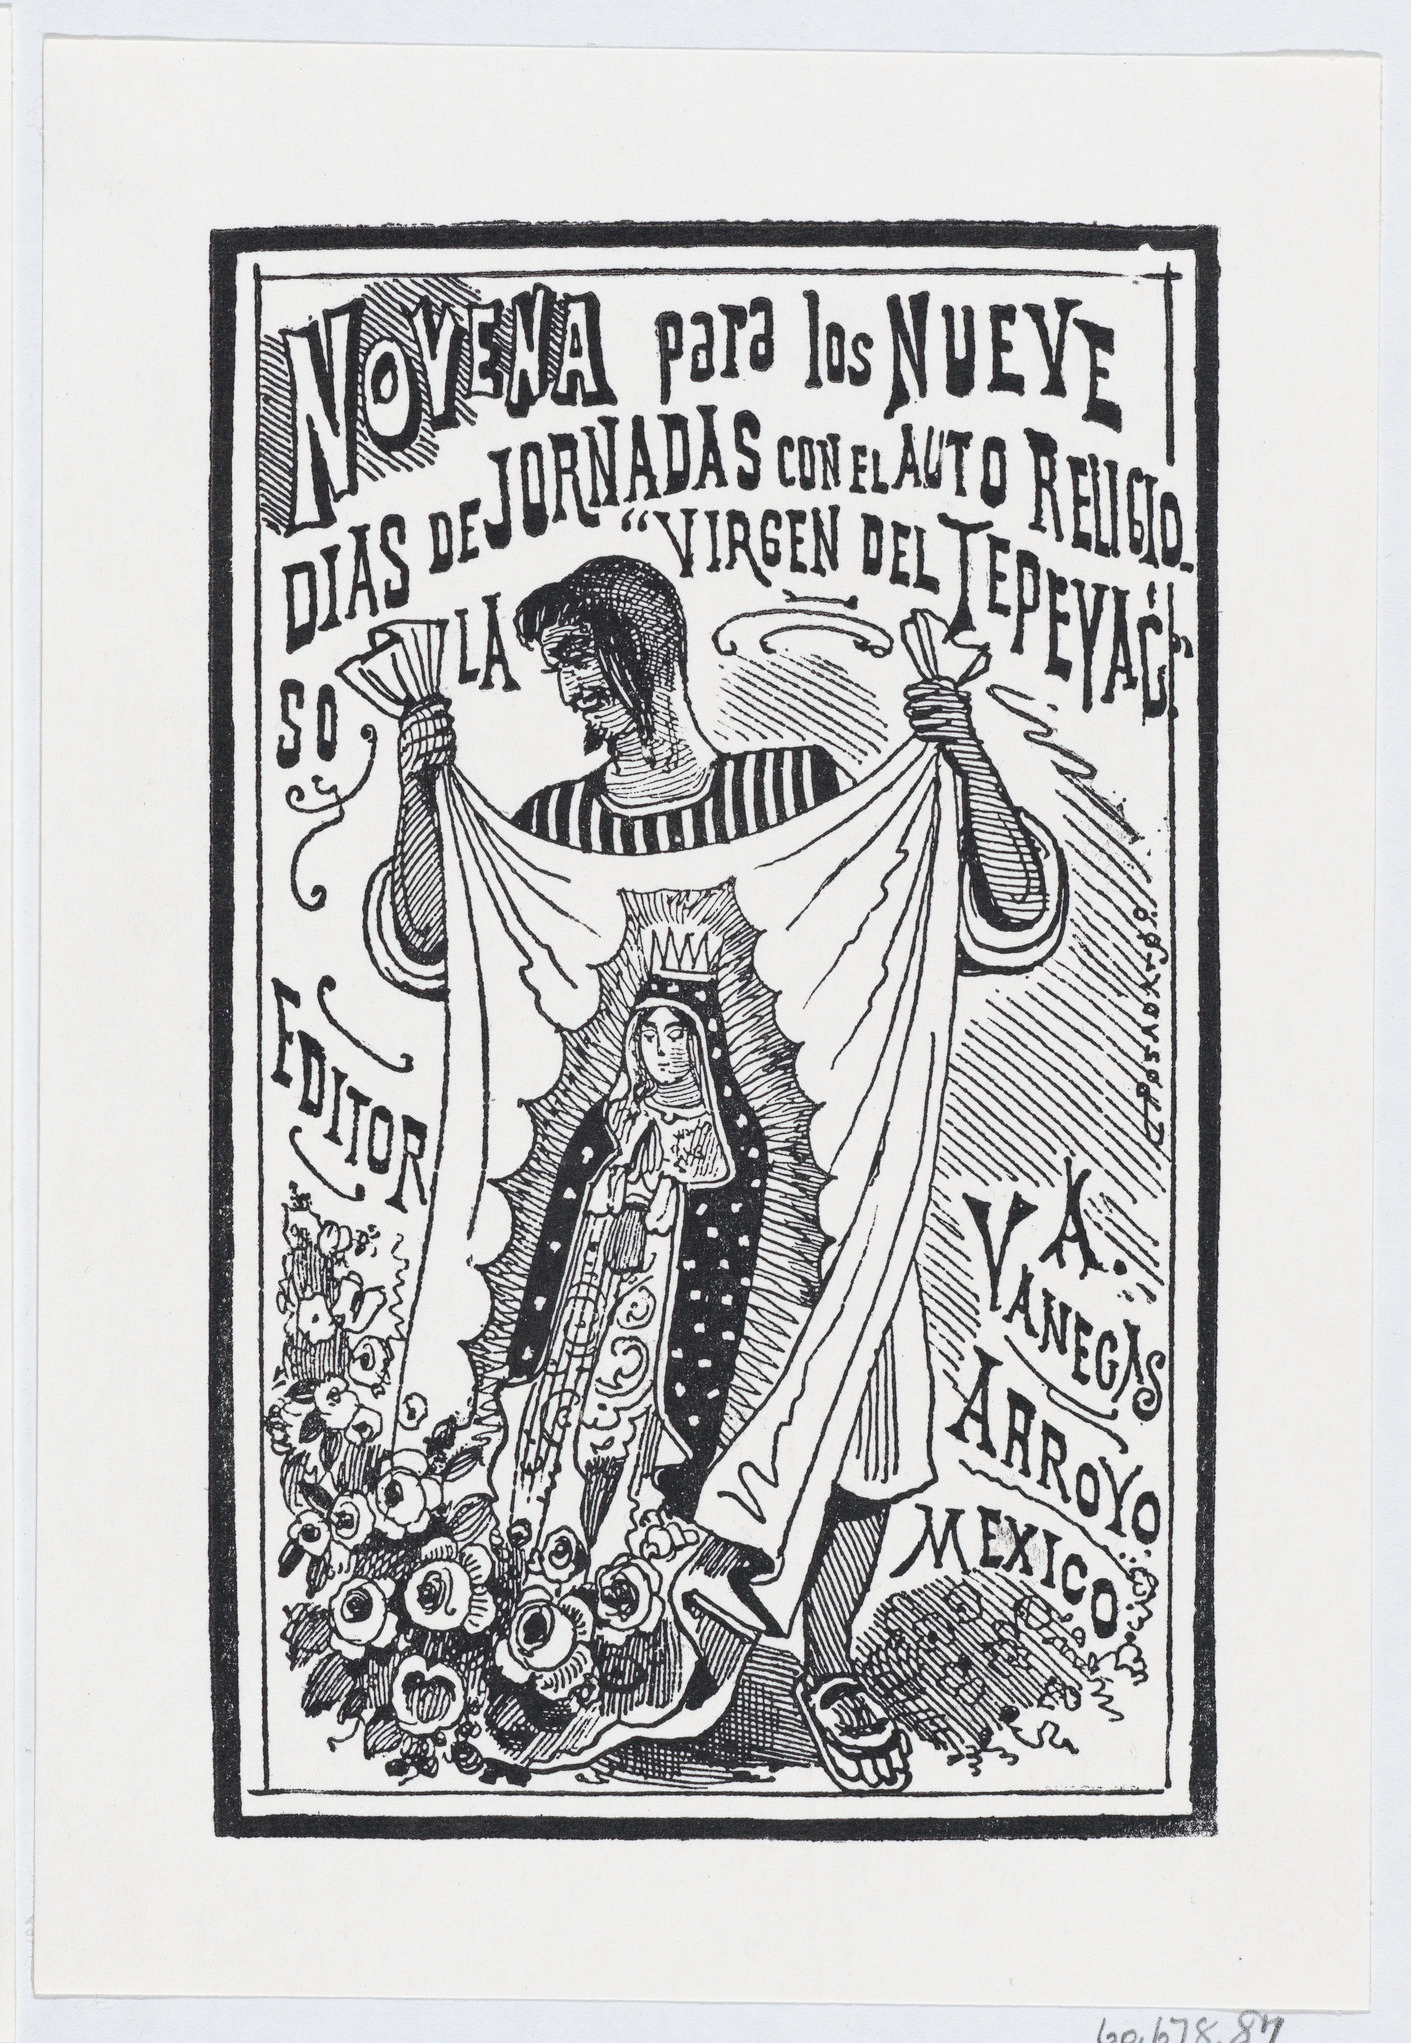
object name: print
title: A man holding up a piece of fabric with an image of the Virgin, illustration for 'Novena para los nueve dias de jornadas con el auto religioso la Virgin de Tepayac'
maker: josé guadalupe posada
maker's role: artist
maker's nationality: mexican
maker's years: 1852-1913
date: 1898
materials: metal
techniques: engraving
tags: men,virgin mary